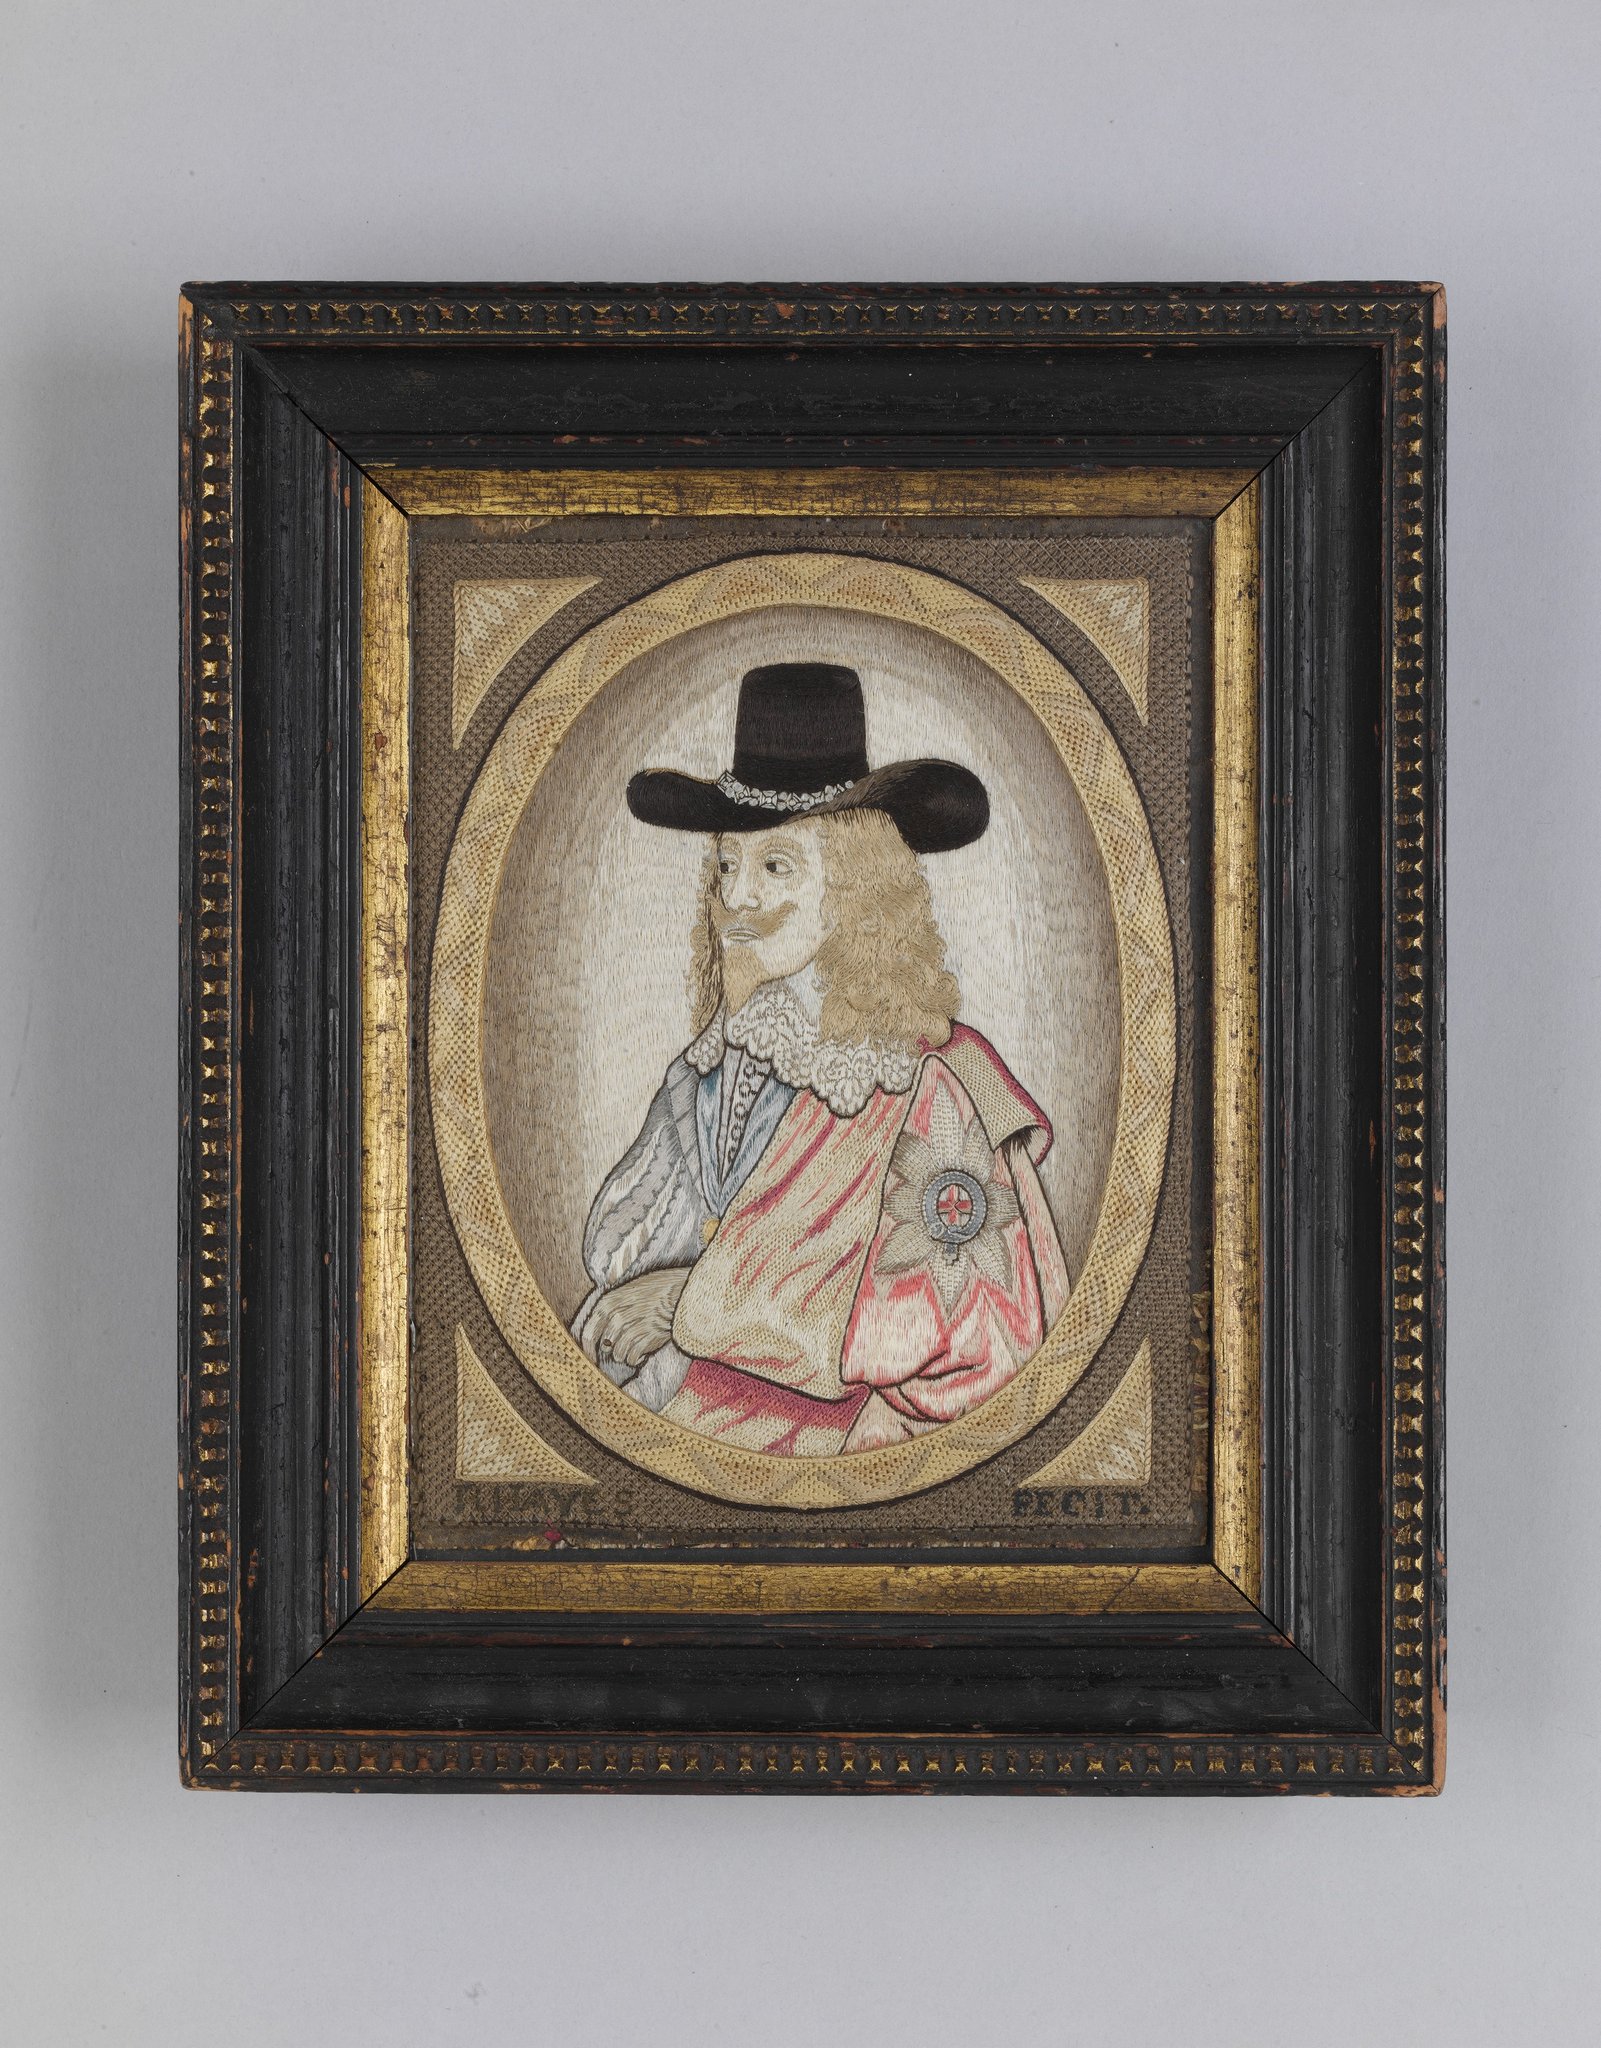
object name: portrait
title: Charles I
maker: r. hayes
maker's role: maker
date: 1649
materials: silk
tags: kings,men,portraits